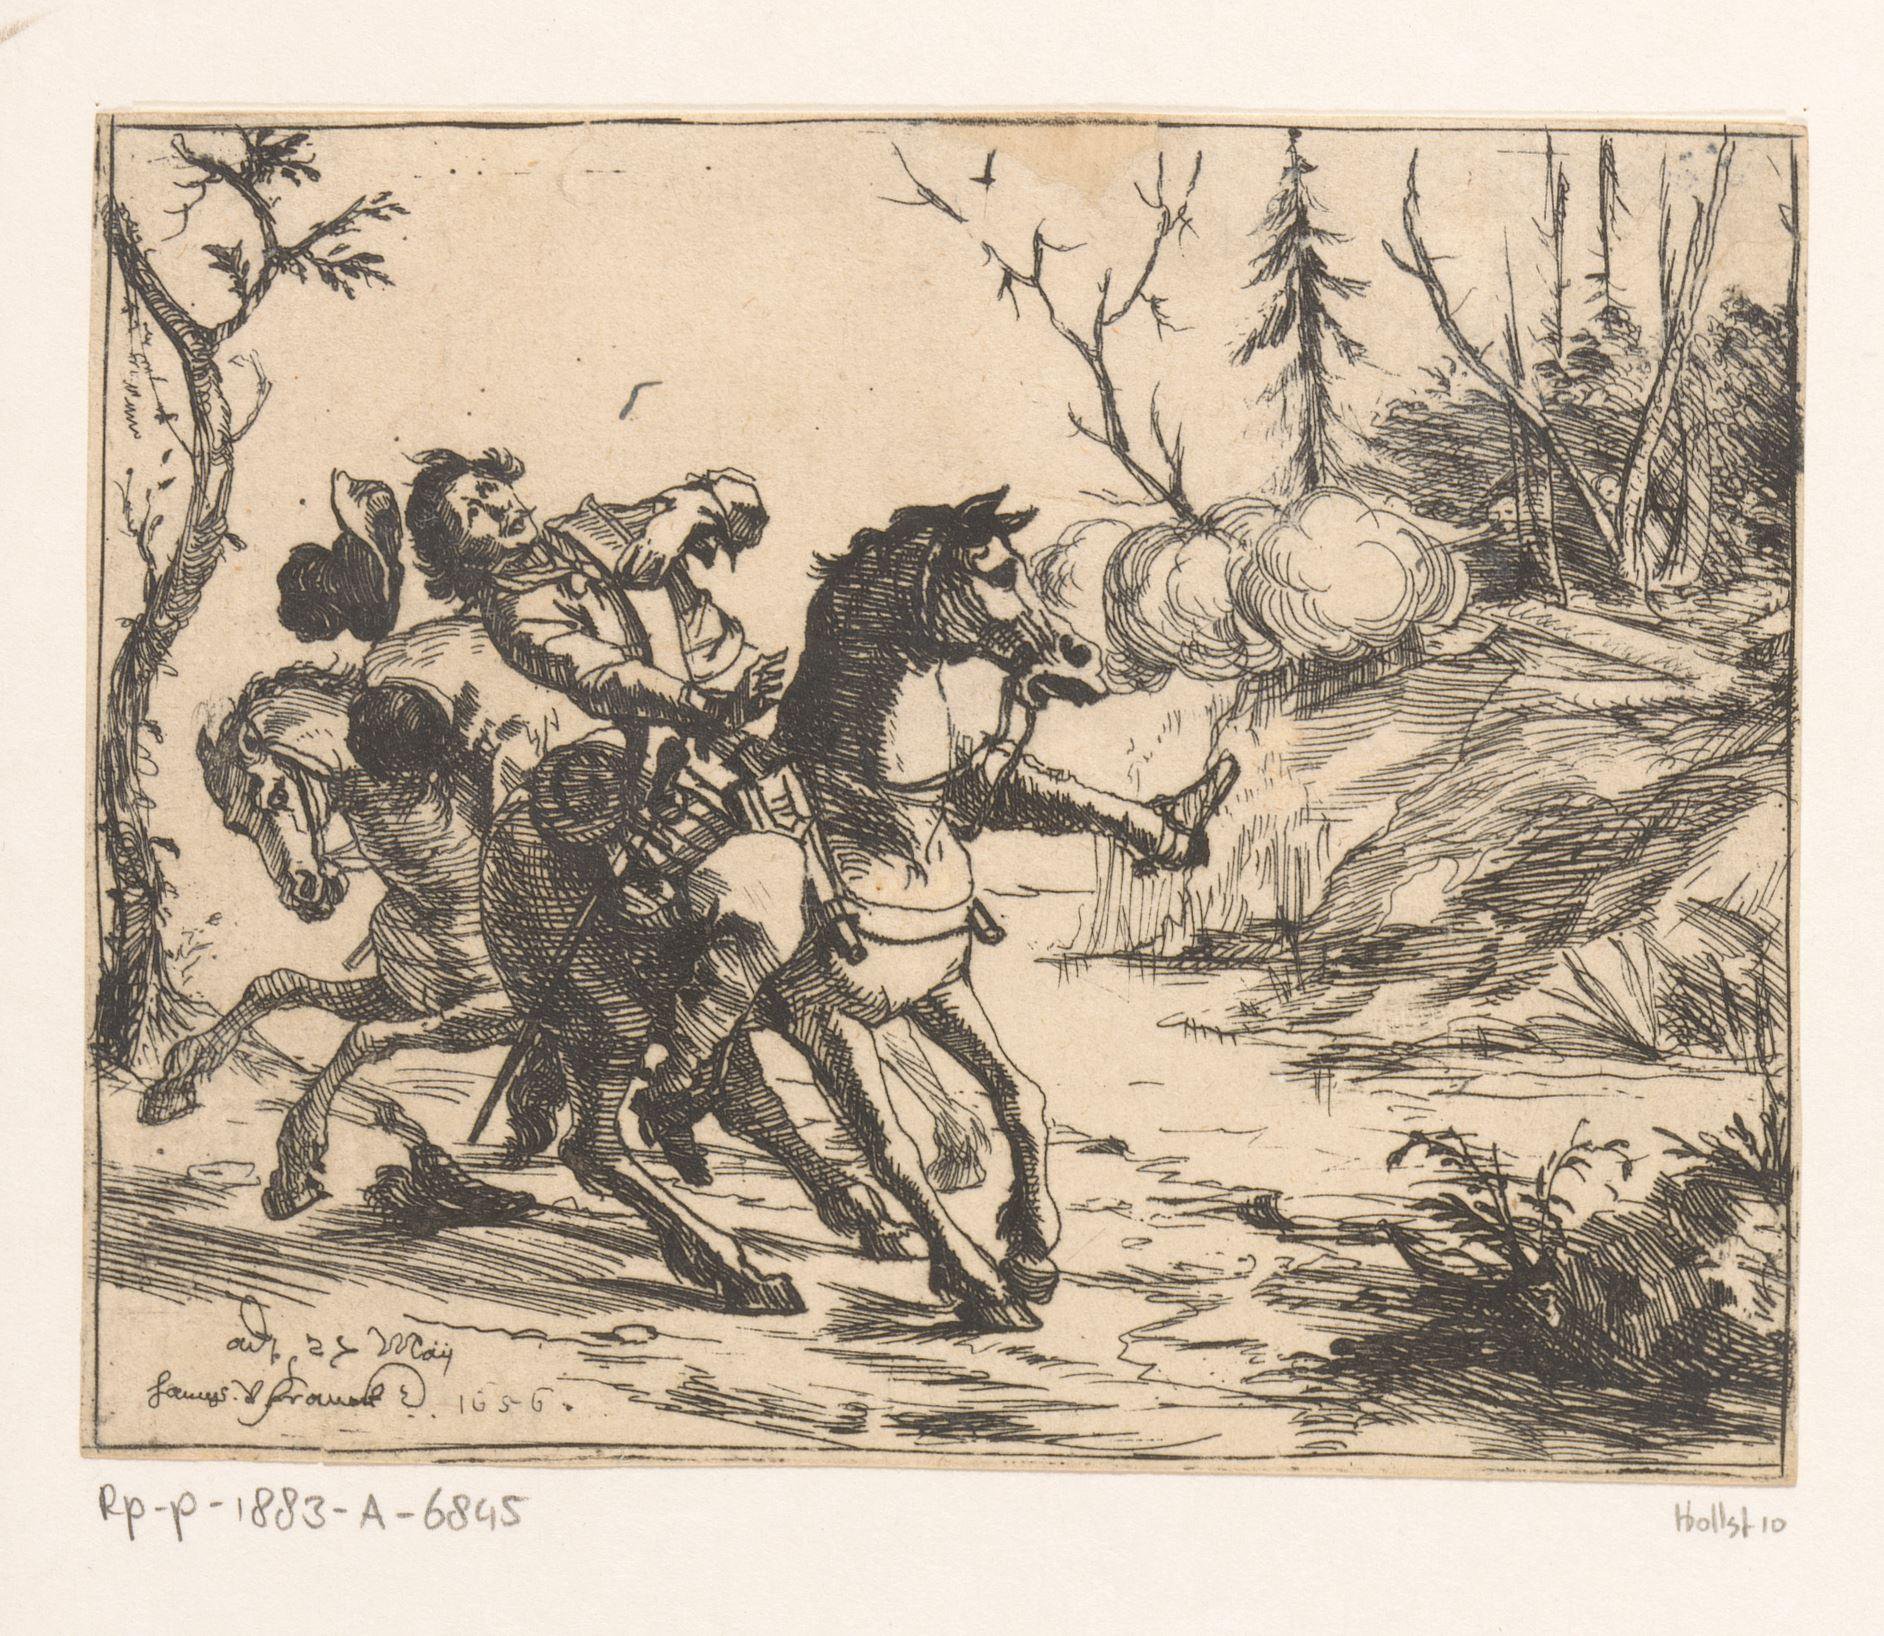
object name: print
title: Twee ruiters in een hinderlaag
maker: hans ulrich franck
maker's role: draughtsman, print maker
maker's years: 1603-1680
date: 1656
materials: paper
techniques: etching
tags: riding a horse, ass, or mule; rider, horseman, surprise attack (from ambush)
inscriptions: collector's mark: Lugt 2228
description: Prent uit een serie van vijfentwintig militaire voorstellingen, waarvan tien in de collectie van het RMA aanwezig zijn.